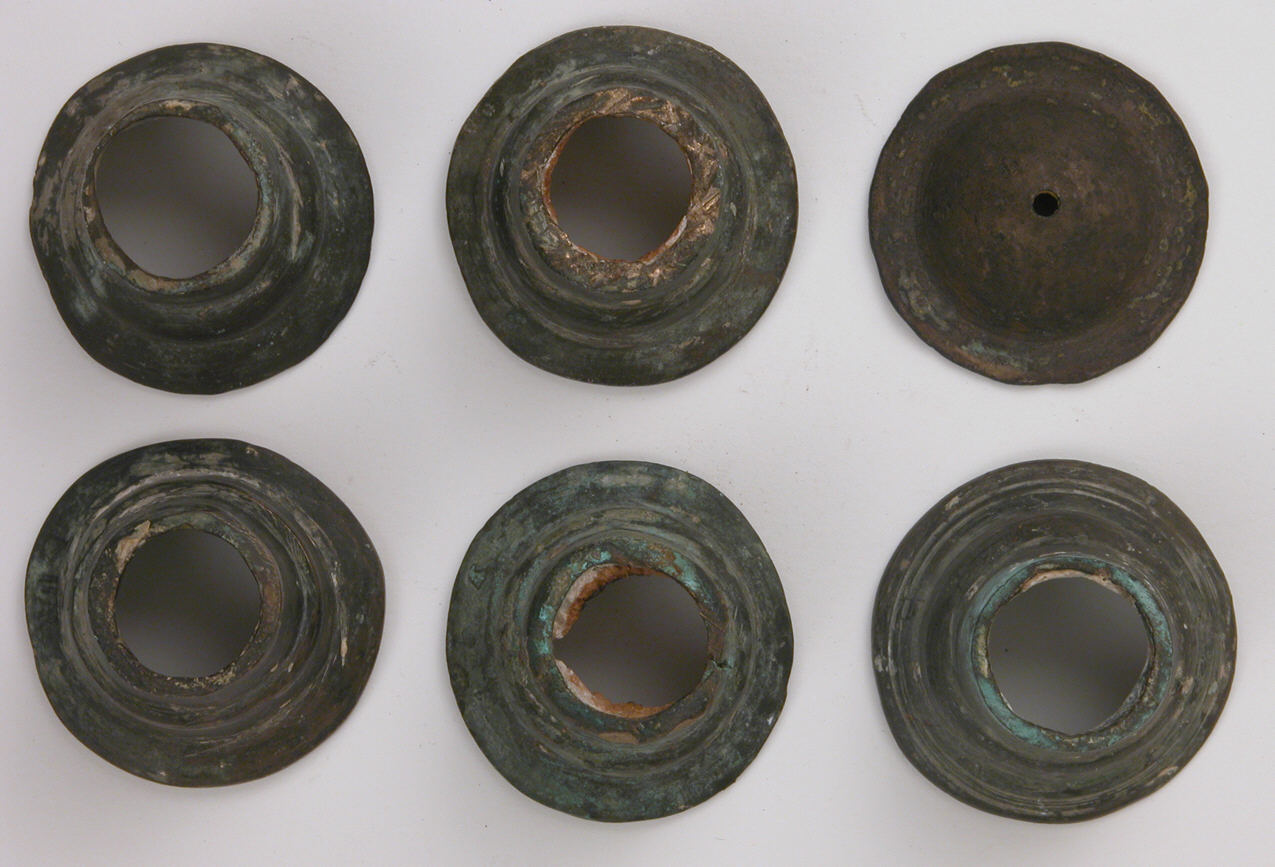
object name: cymbal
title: Cymbals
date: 401-800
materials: bronze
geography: palestine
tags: musical instruments